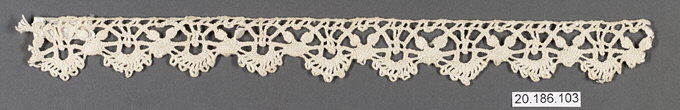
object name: edging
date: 1601-1700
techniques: lace